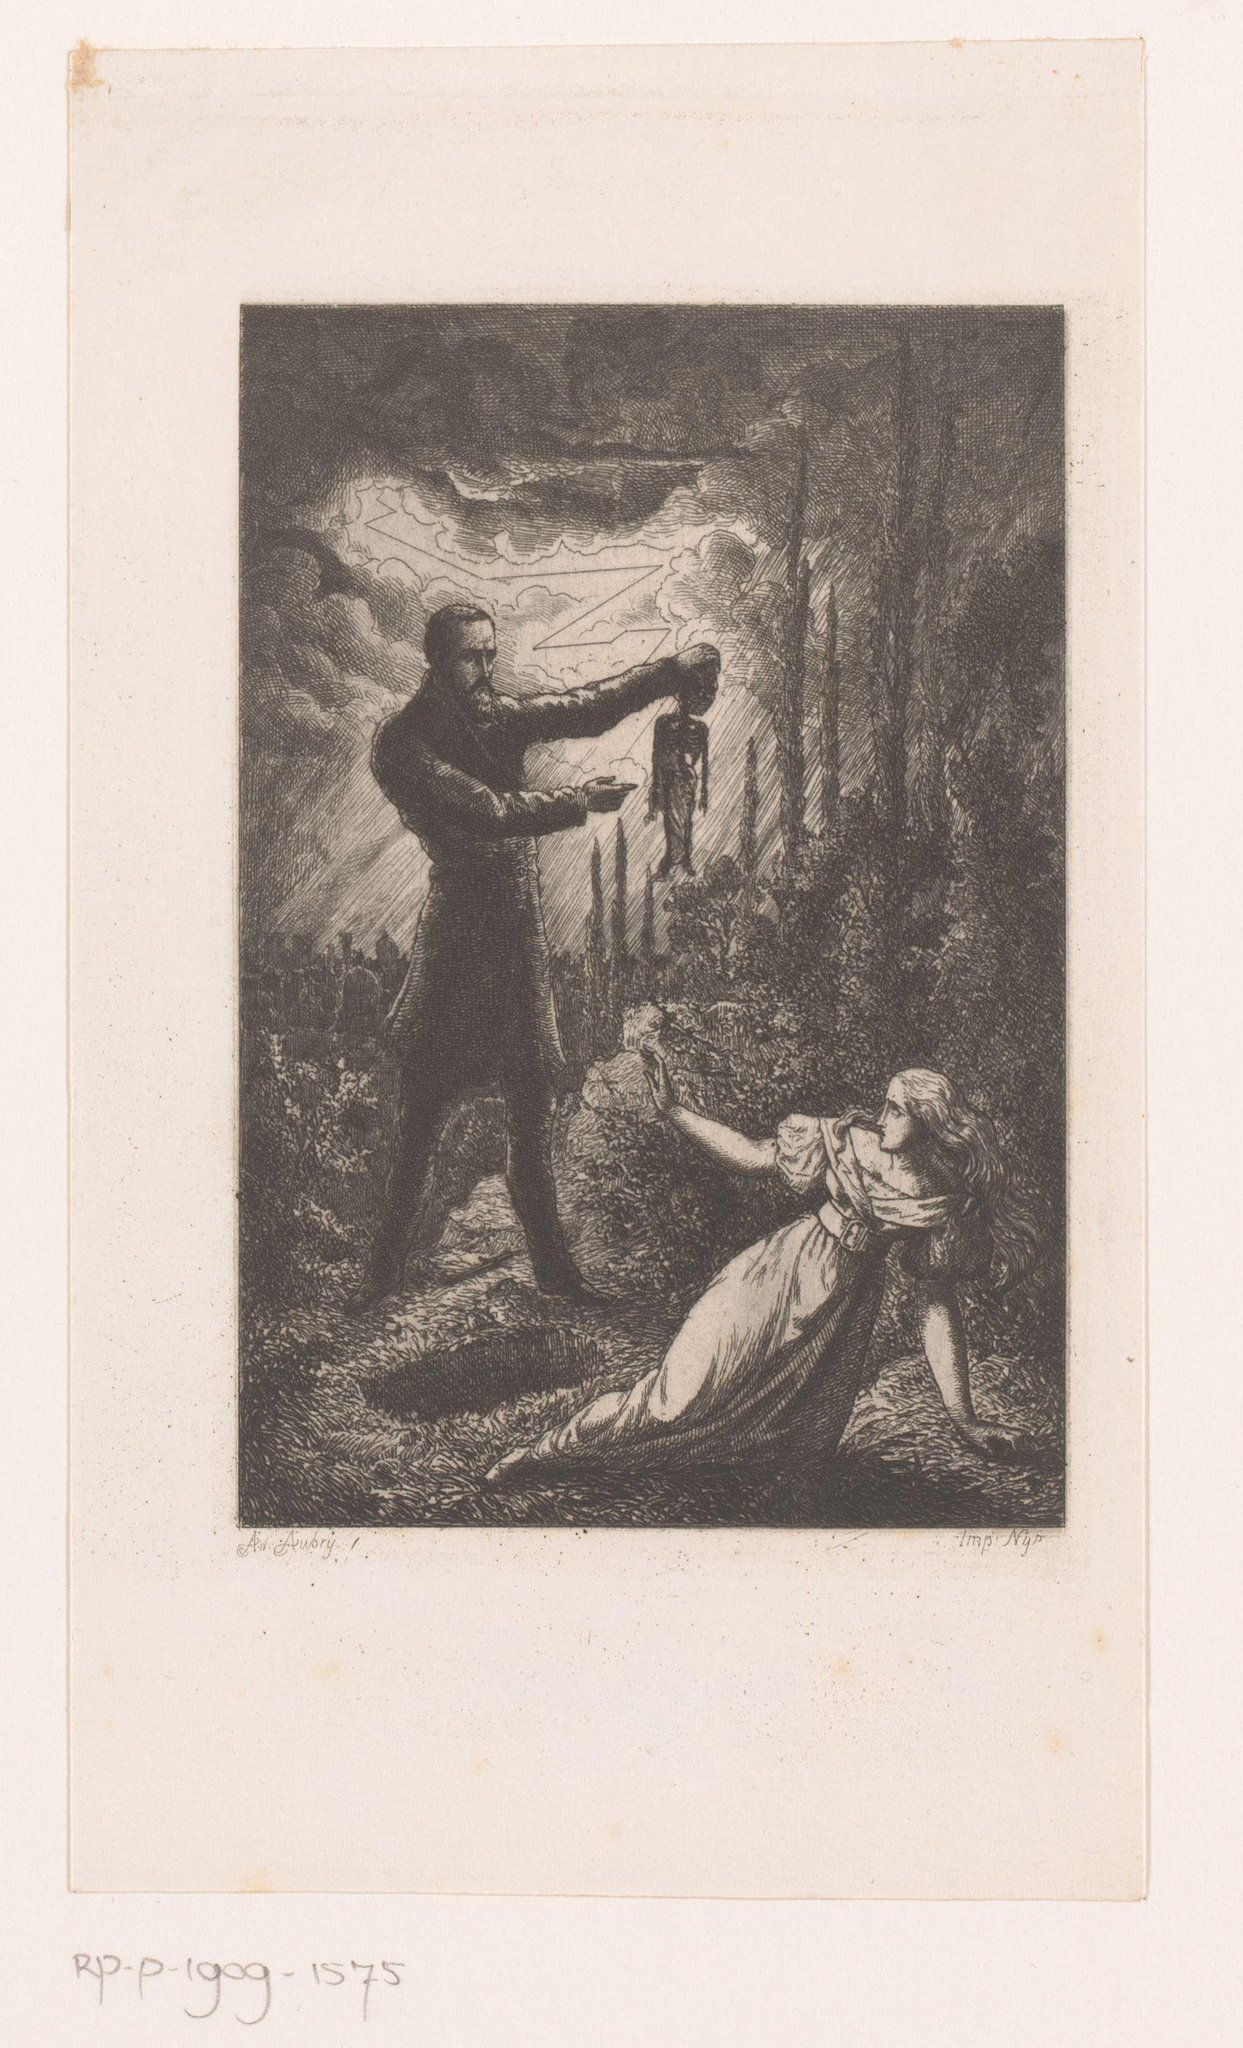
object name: book illustration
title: Nachtscène waarin een man bij een open graf een babyskelet toont aan een jonge vrouw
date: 1872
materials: paper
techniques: etching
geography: brussels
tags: thunderstorm, (human) skeleton, night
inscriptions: collector's mark: Lugt 2228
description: Prent uit: Borel, Petrus. Champavert, contes immoraux. Brussel: J. Blanche, 1872.